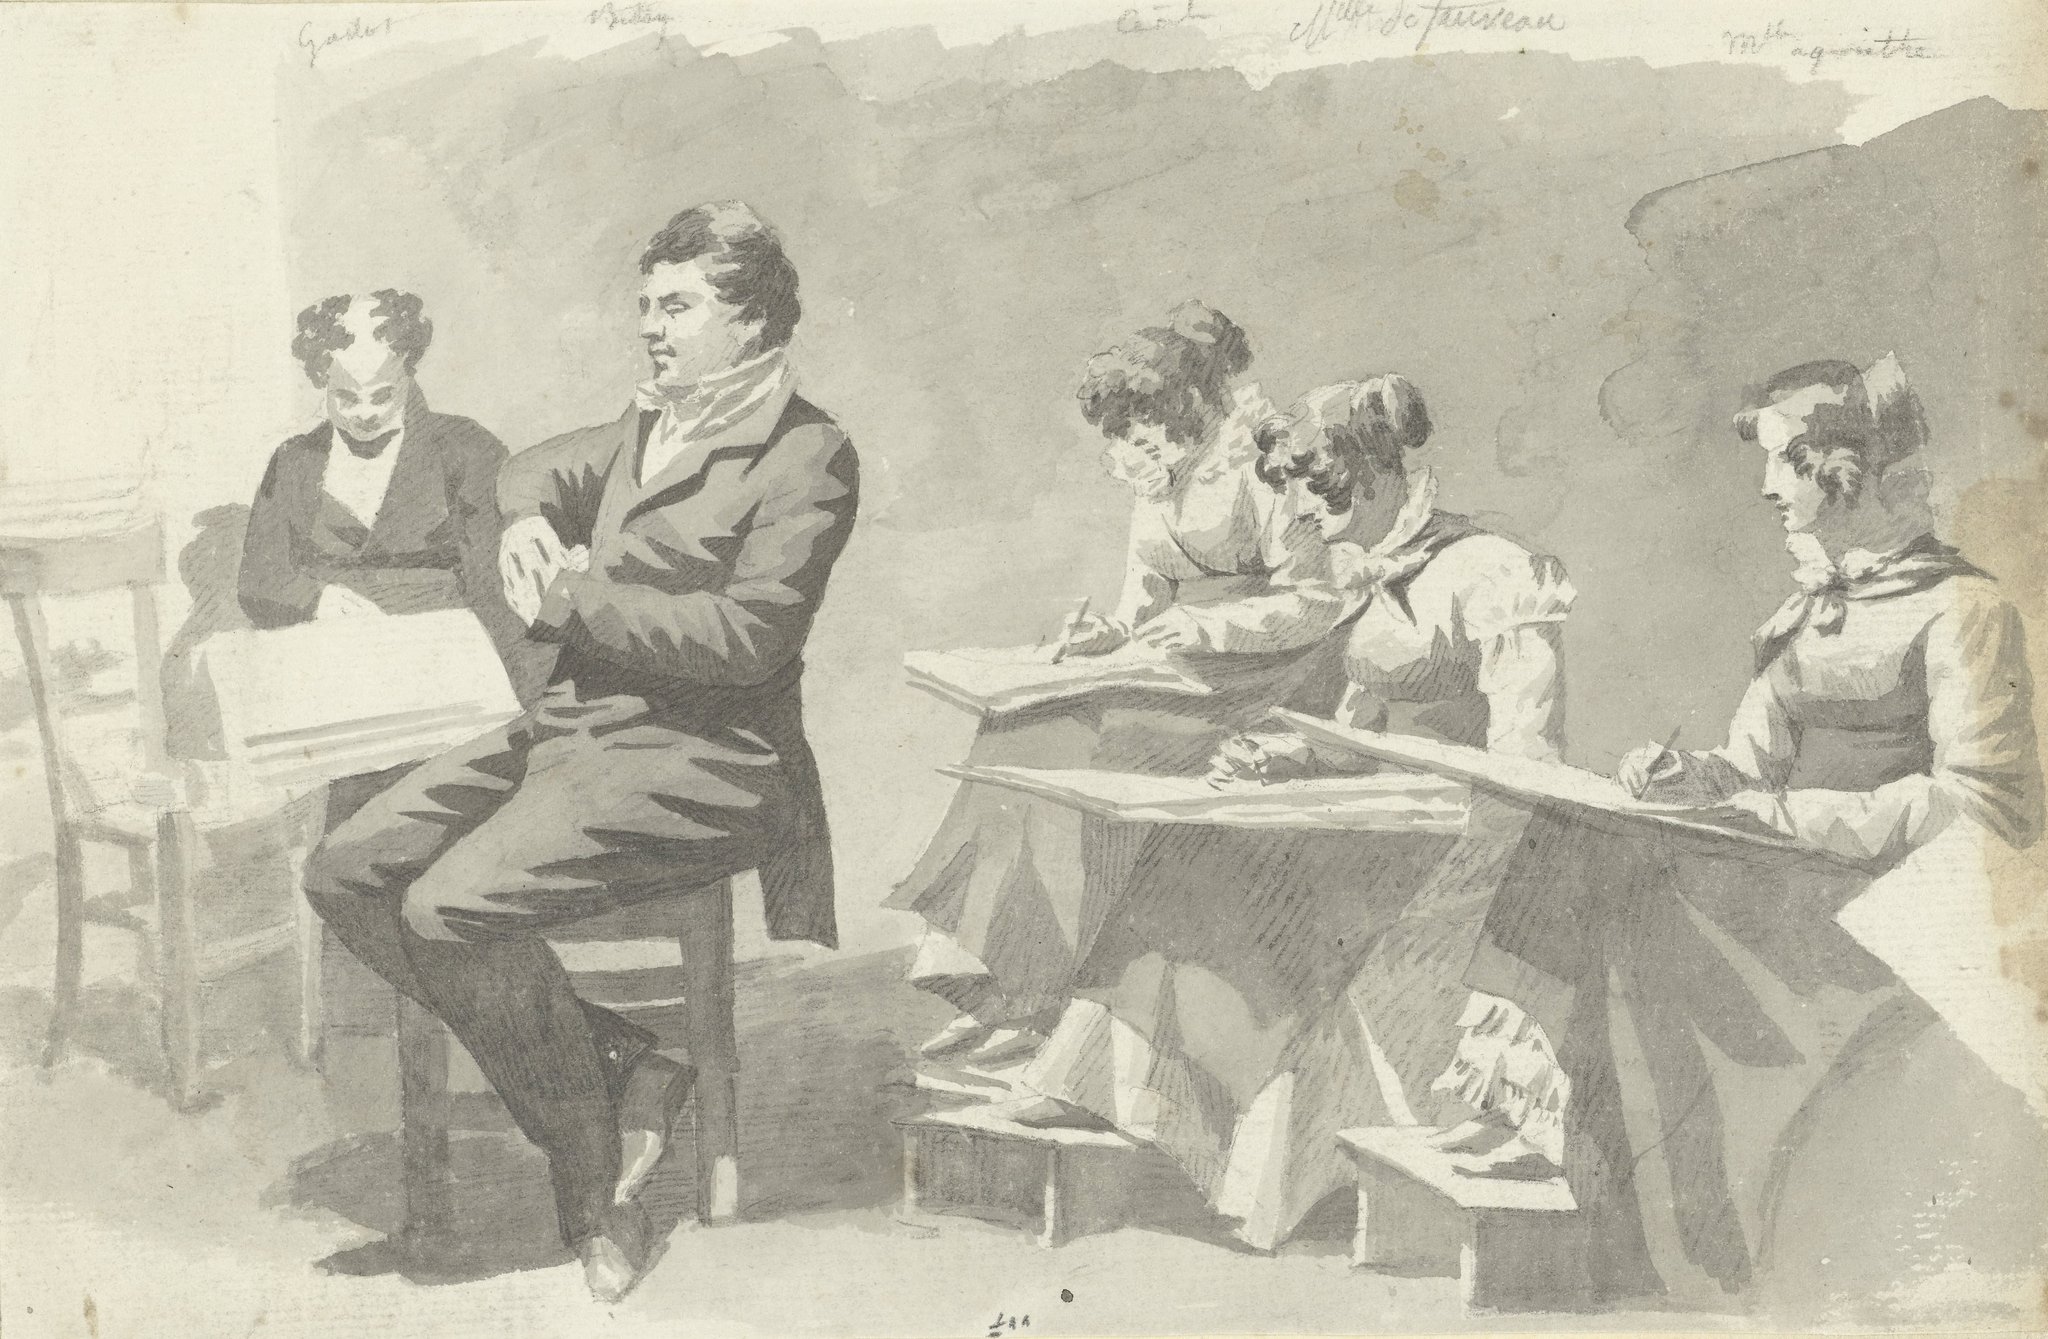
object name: drawing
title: Tekenend gezelschap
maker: camille chenou-levesque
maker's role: draughtsman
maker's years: 1818-1886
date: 1800-1900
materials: paper, pencil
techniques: brush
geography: france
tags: drawing-lesson, place or institution of education and training of the artist, e.g.: academy of art